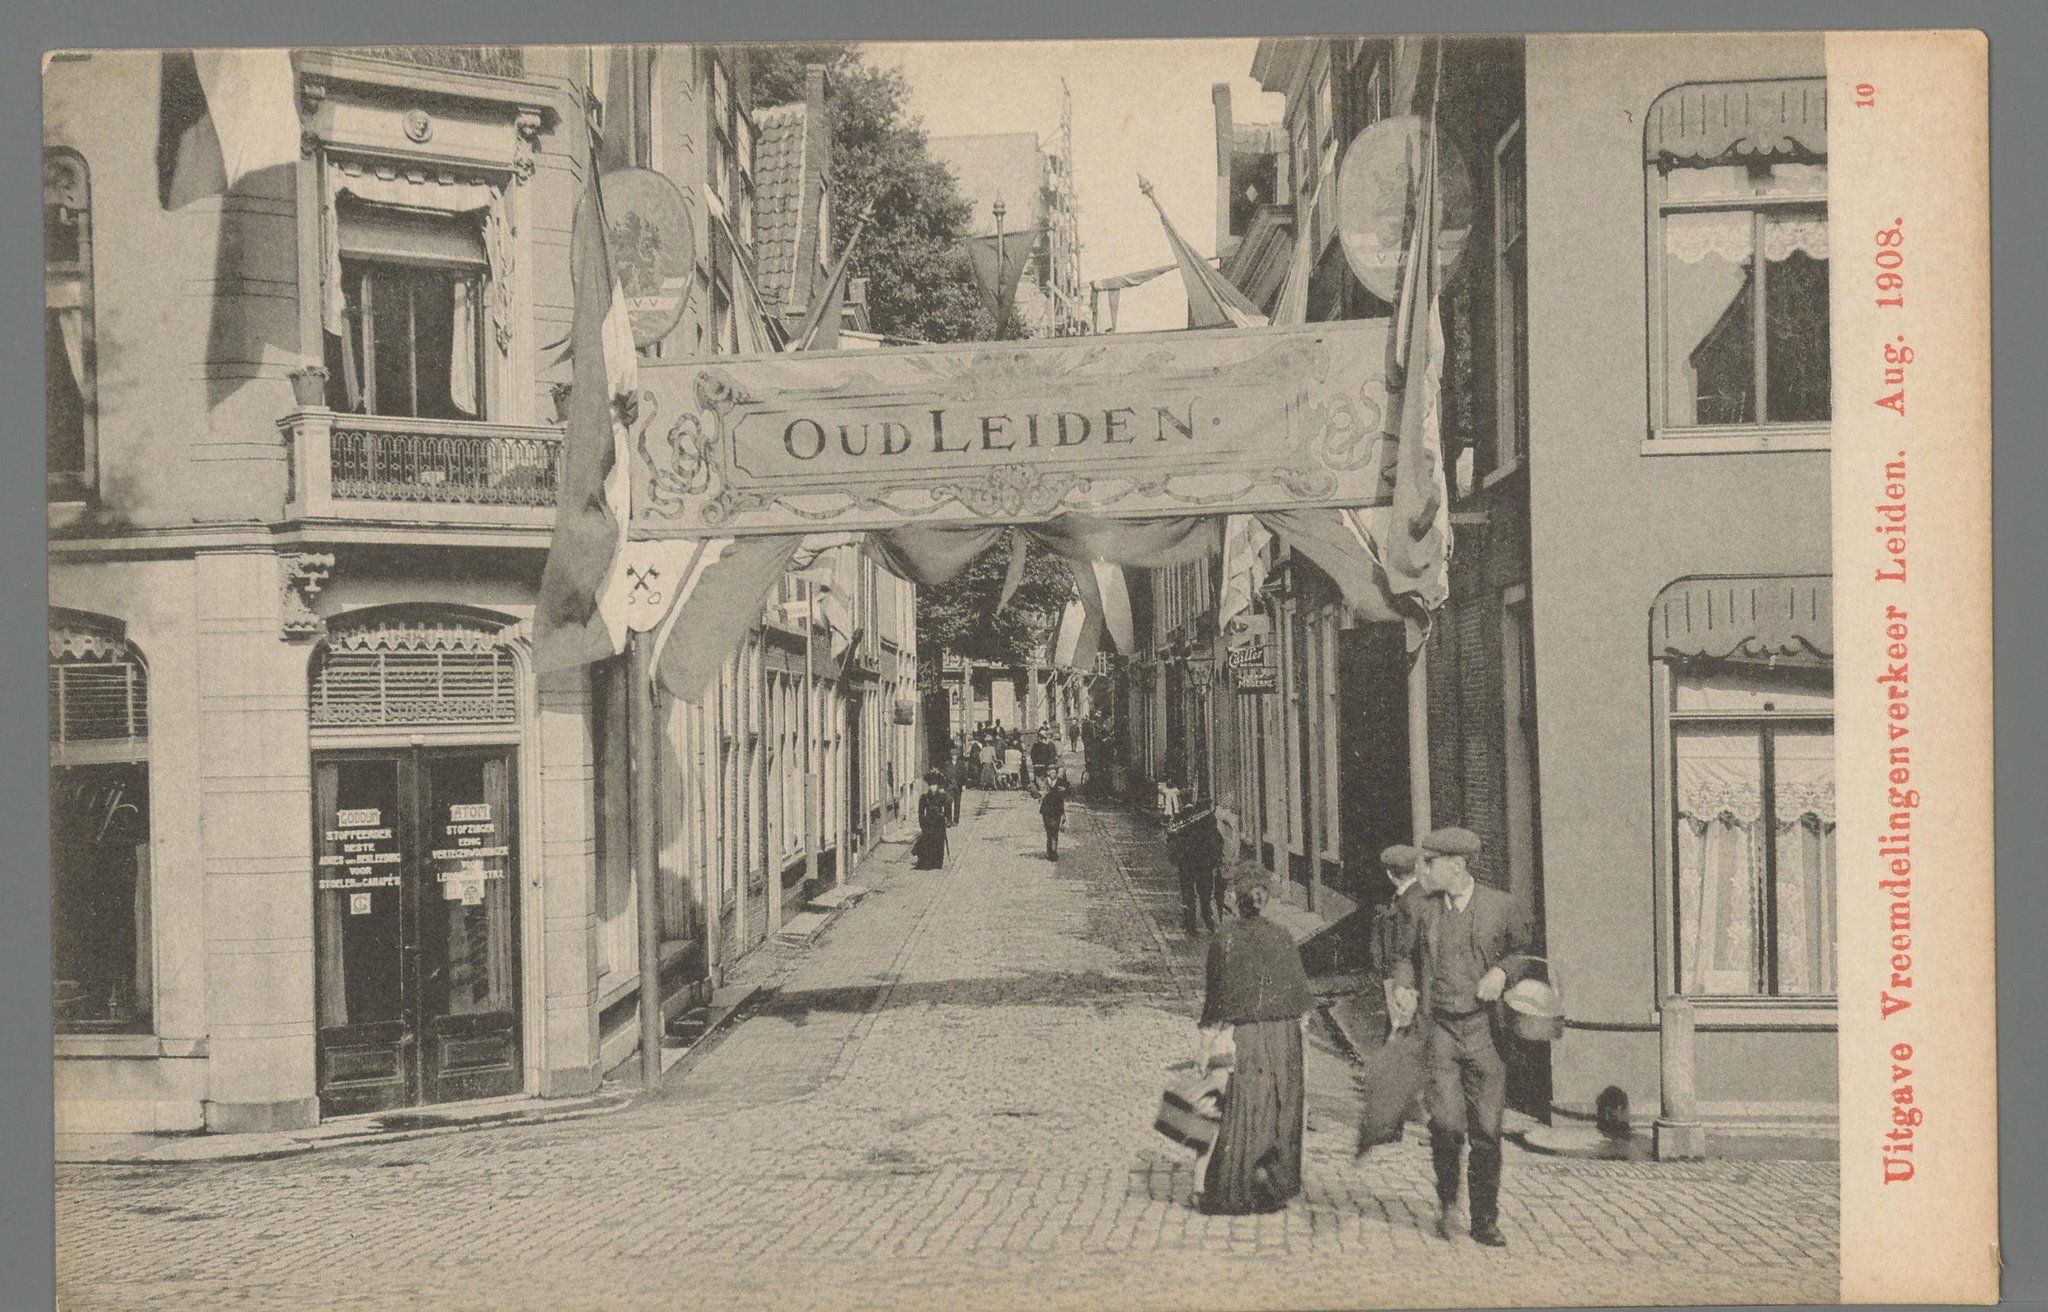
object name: photomechanical print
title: Versierde straat tijdens de Oud-Hollandse feesten te Leiden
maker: Anonymous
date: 1908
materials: cardboard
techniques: photograph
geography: haarlem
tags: street, festivities, leiden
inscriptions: date